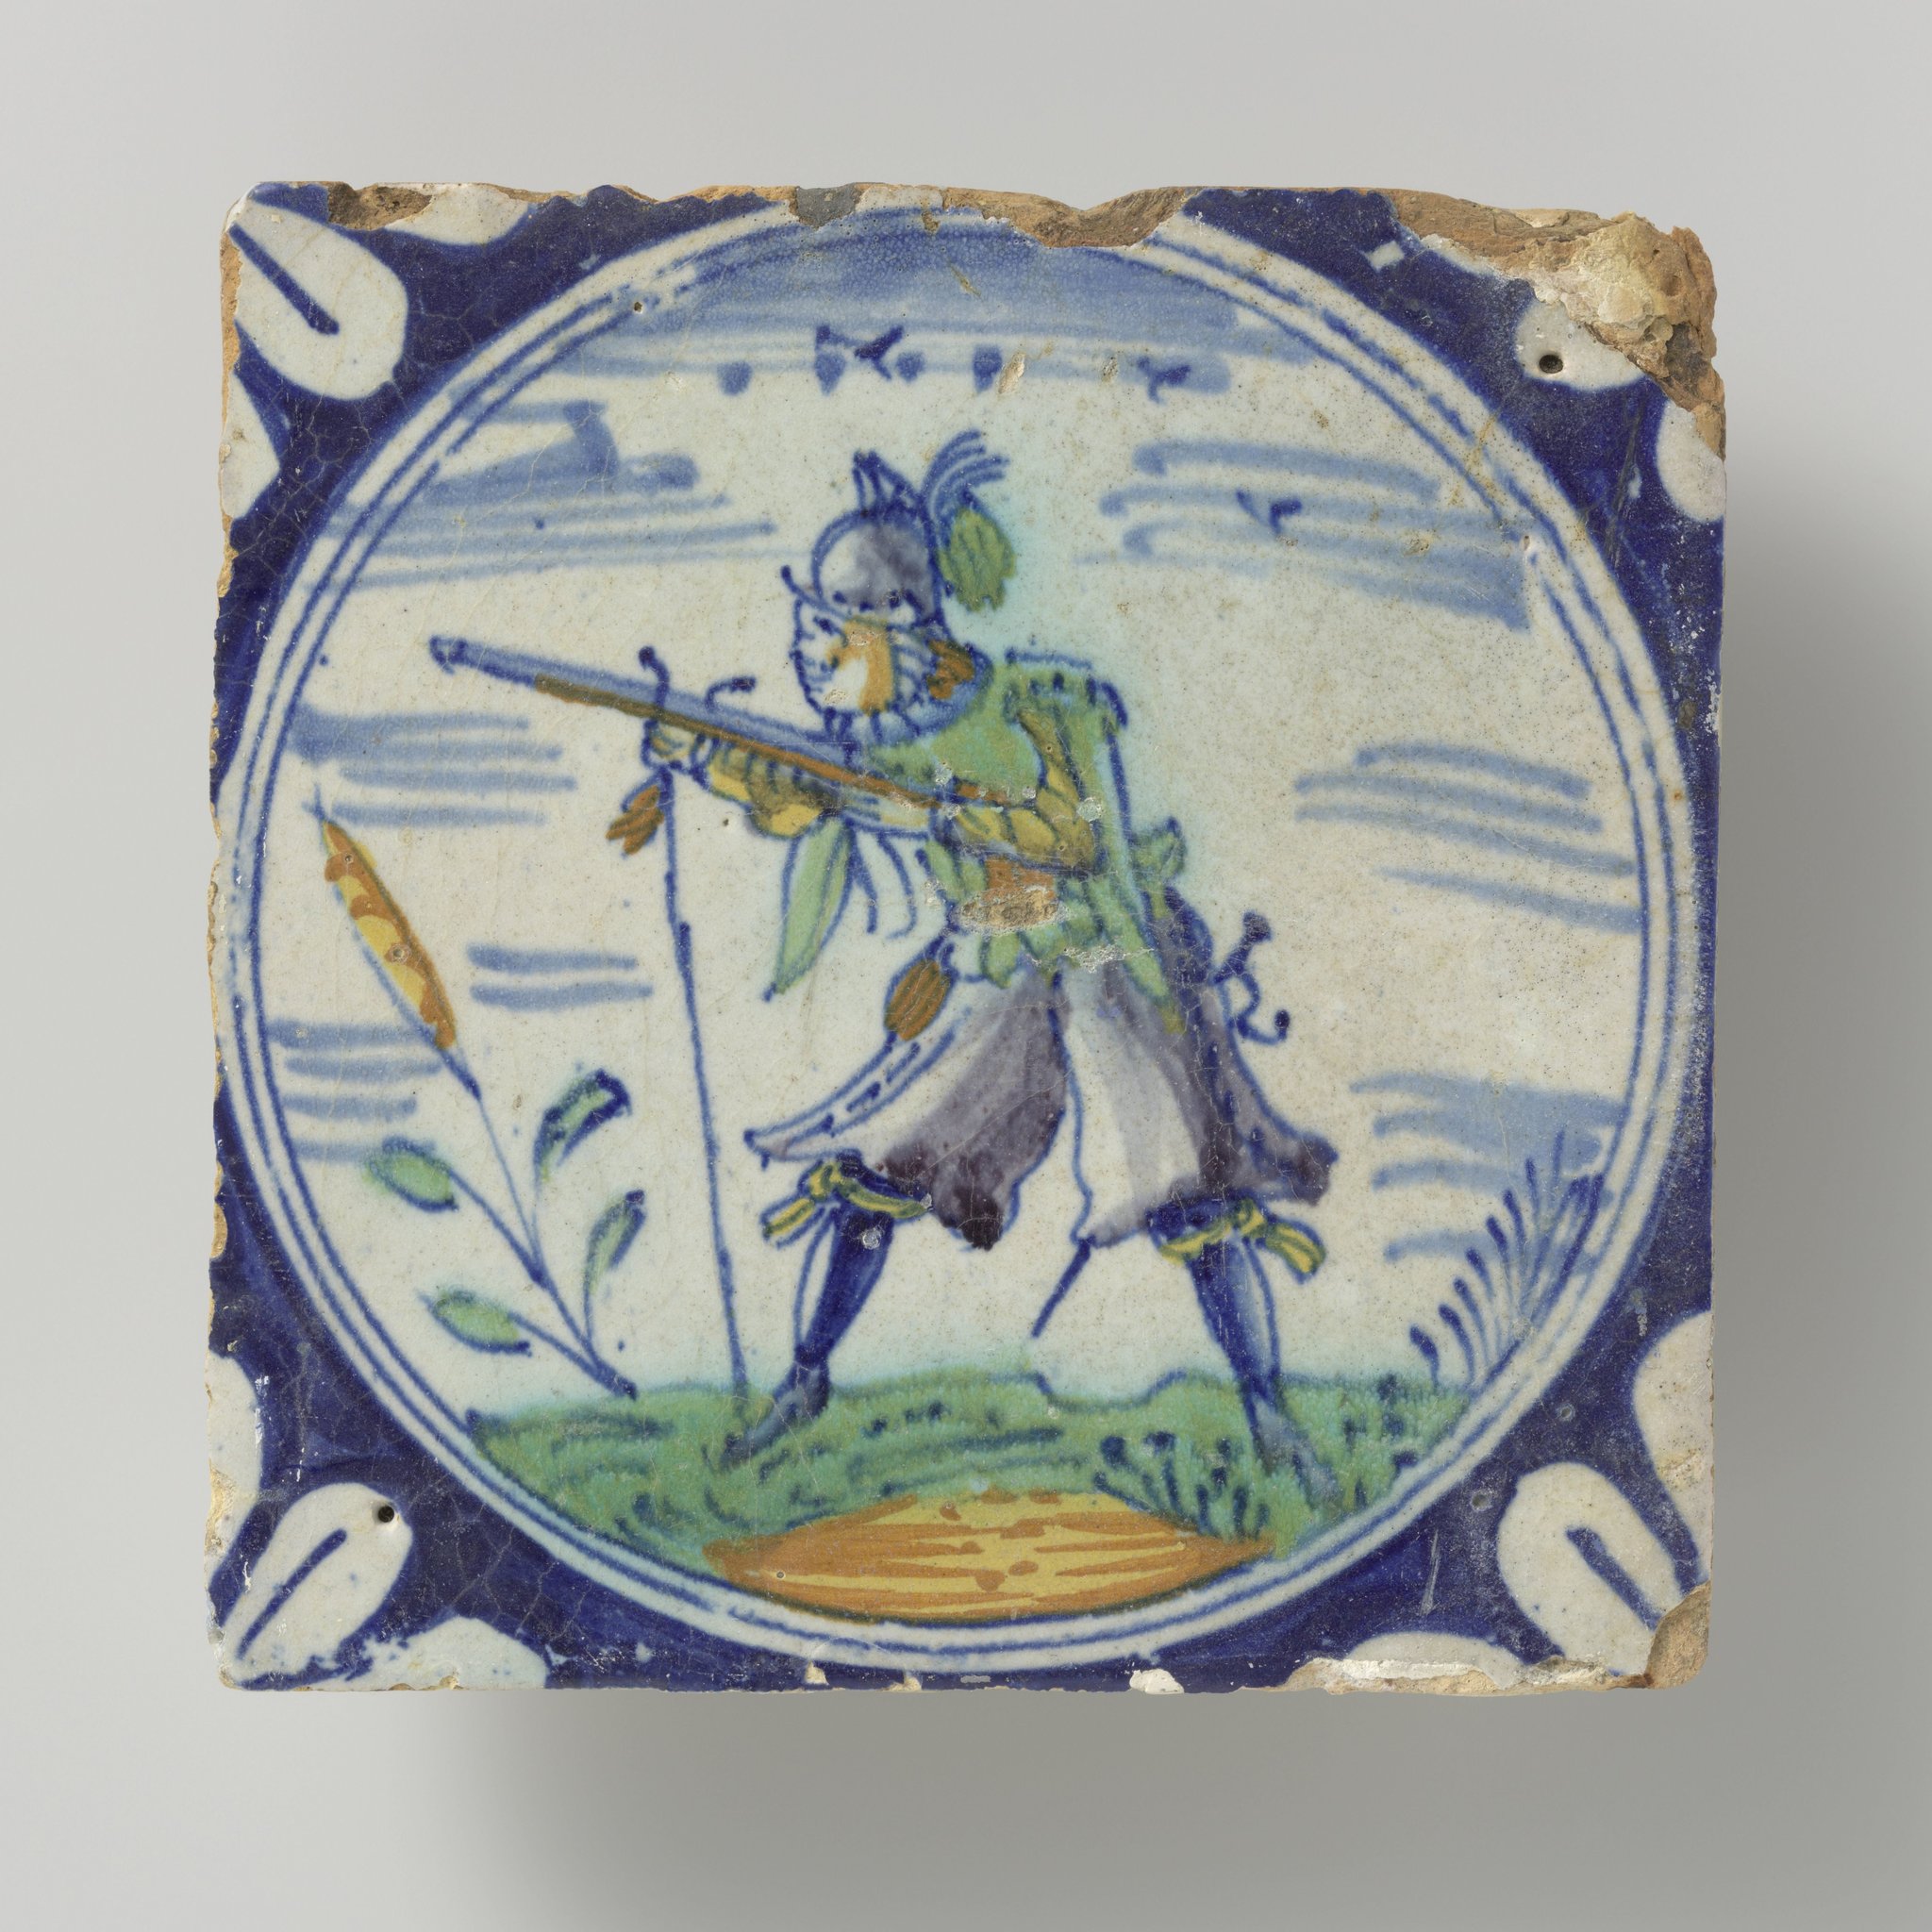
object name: tile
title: Tegel, veelkleurig beschilderd met een soldaat of een vaandeldrager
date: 1625-1700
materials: earthenware, glaze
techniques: maiolica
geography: netherlands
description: Tegel, veelkleurig beschilderd met een soldaat of een vaandeldrager.